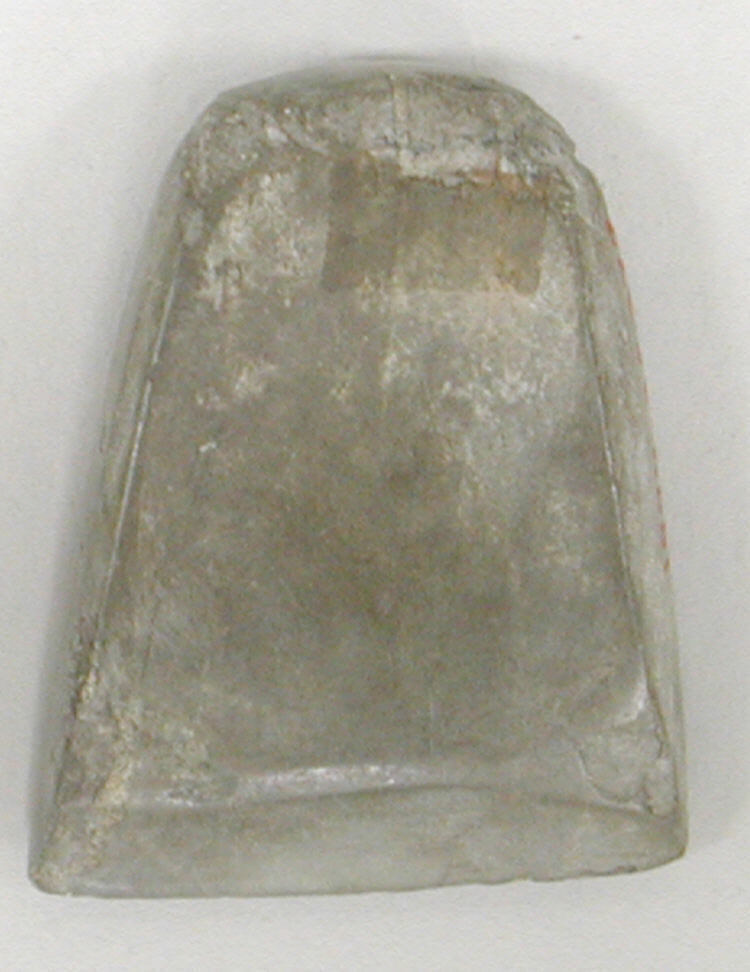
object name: chisel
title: Stone Chisel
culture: mexican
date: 1501-1600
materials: stone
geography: mexico